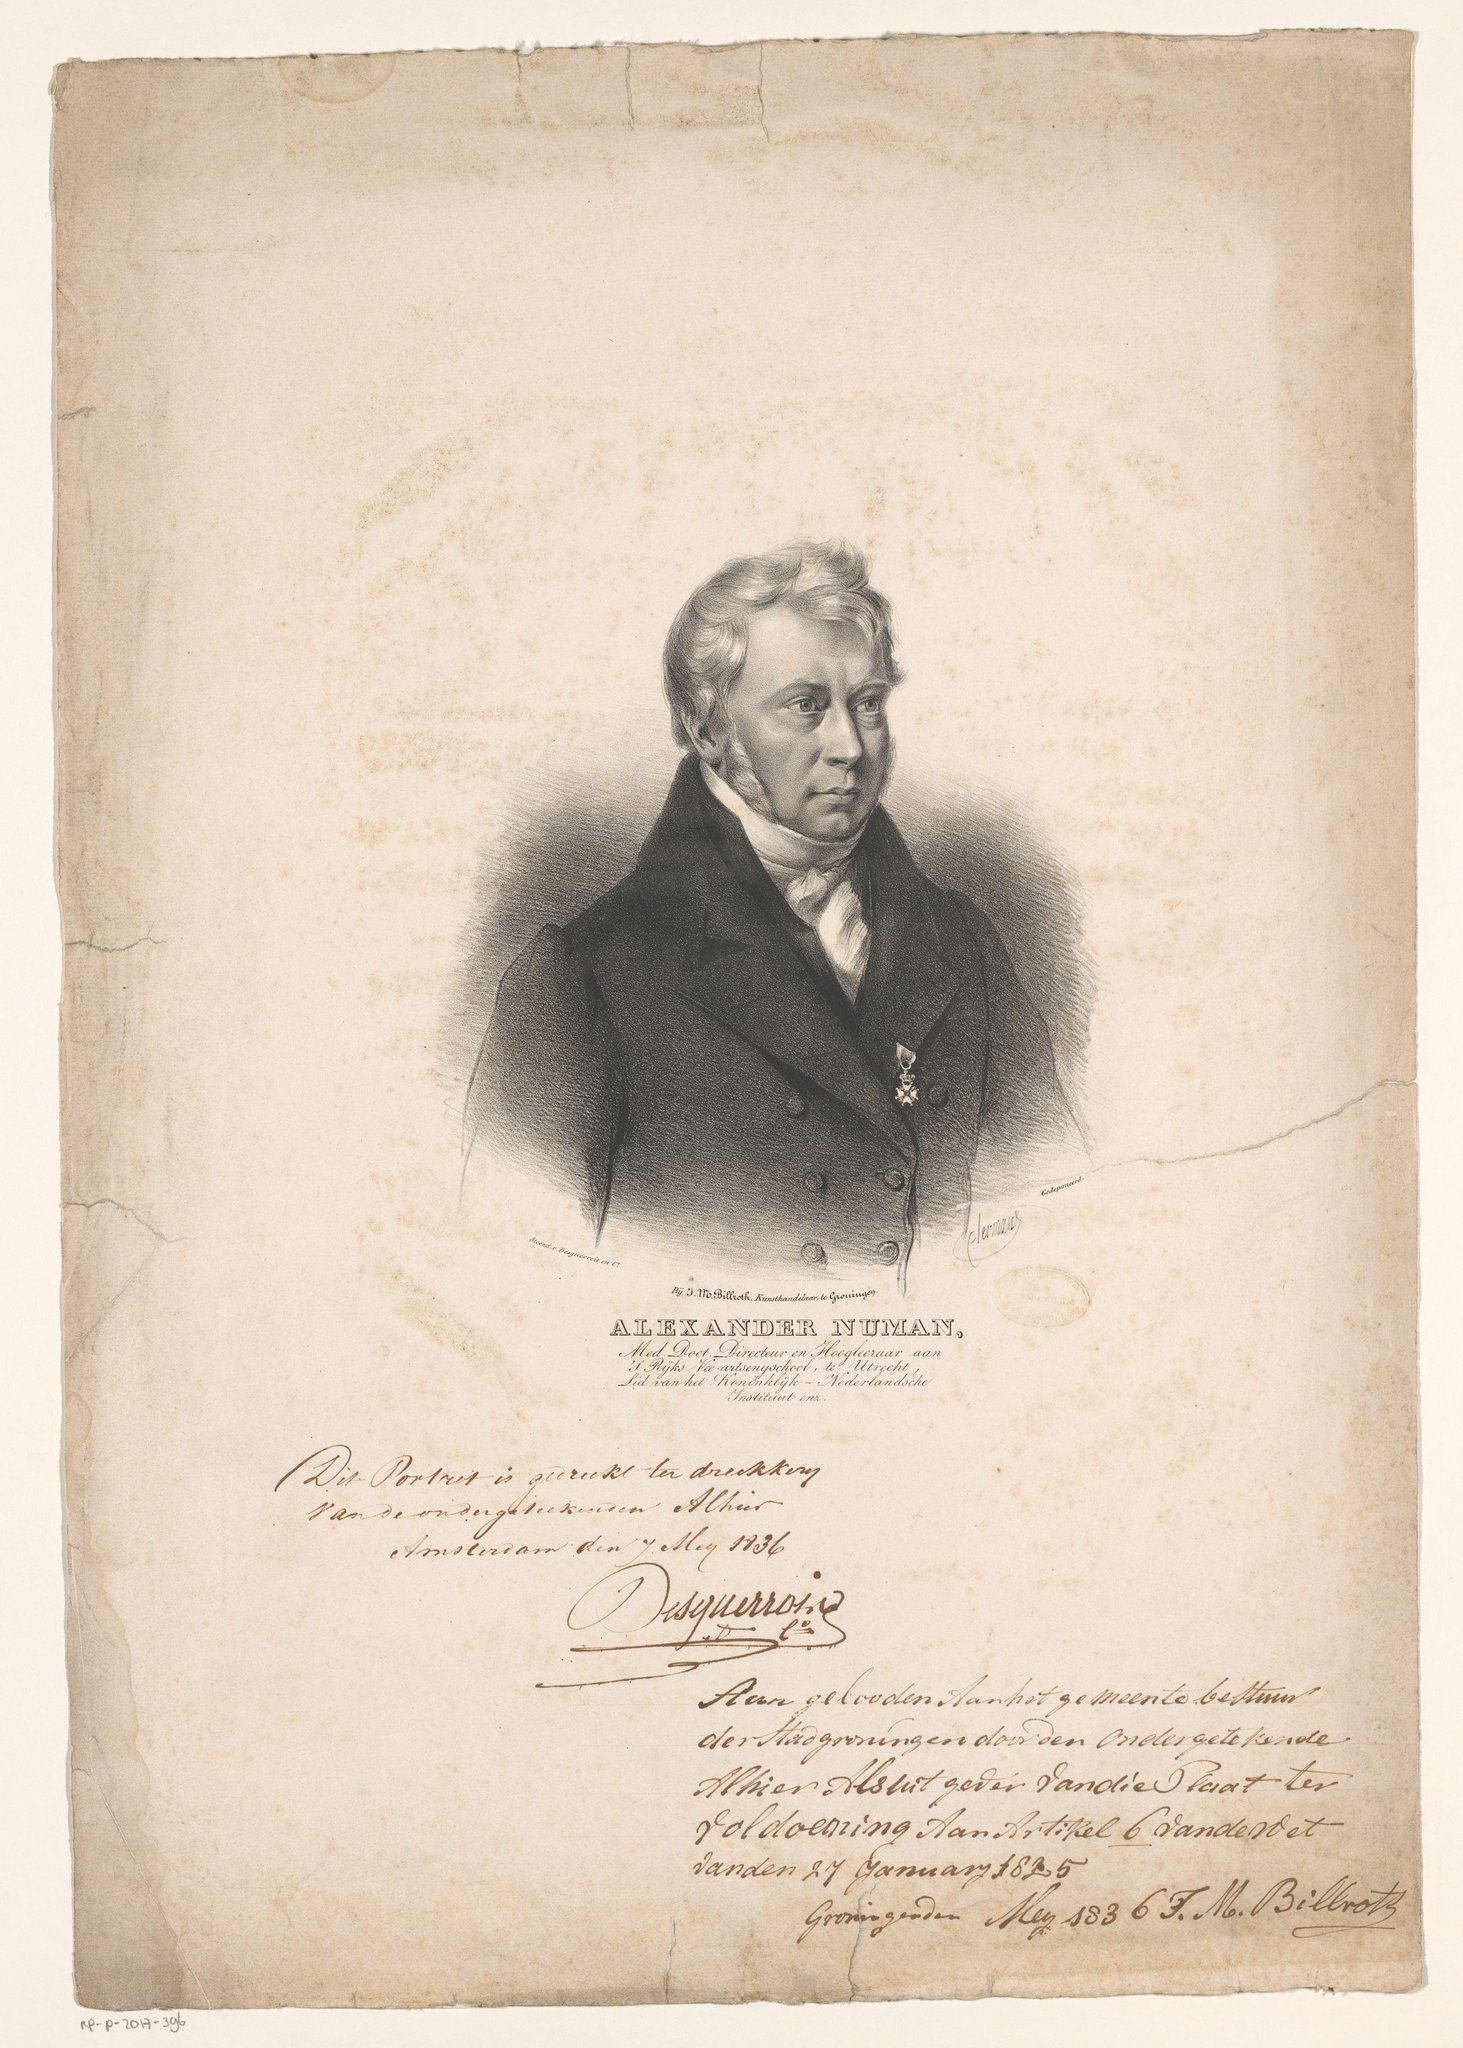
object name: print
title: Portret van Alexander Numan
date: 1836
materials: paper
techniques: lithograph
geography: amsterdam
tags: knighthood order, historical persons (+ (full) bust portrait)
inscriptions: : ‘Gedeponeerd.’, : ‘Aan gebooden aan het gemeentebestuur / der stad groningen door den ondergetekende / alhier als uitgever van die plaat er / voldoening aan Artikel 6 van de wet / van den 27 january 1825 / Groningen Mey 1836 J.M.Bilroth’, : ‘Dit portret is gedrukt ter drukkerij / van de ondergeteekenden alhier / Amsterdam den 7 Mey 1836 / Desguerrois&Co’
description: De geportretteerde kijkt naar rechts en draagt een ridderorde aan de revers van zijn jas. Onder het portret zijn naam en beroep.